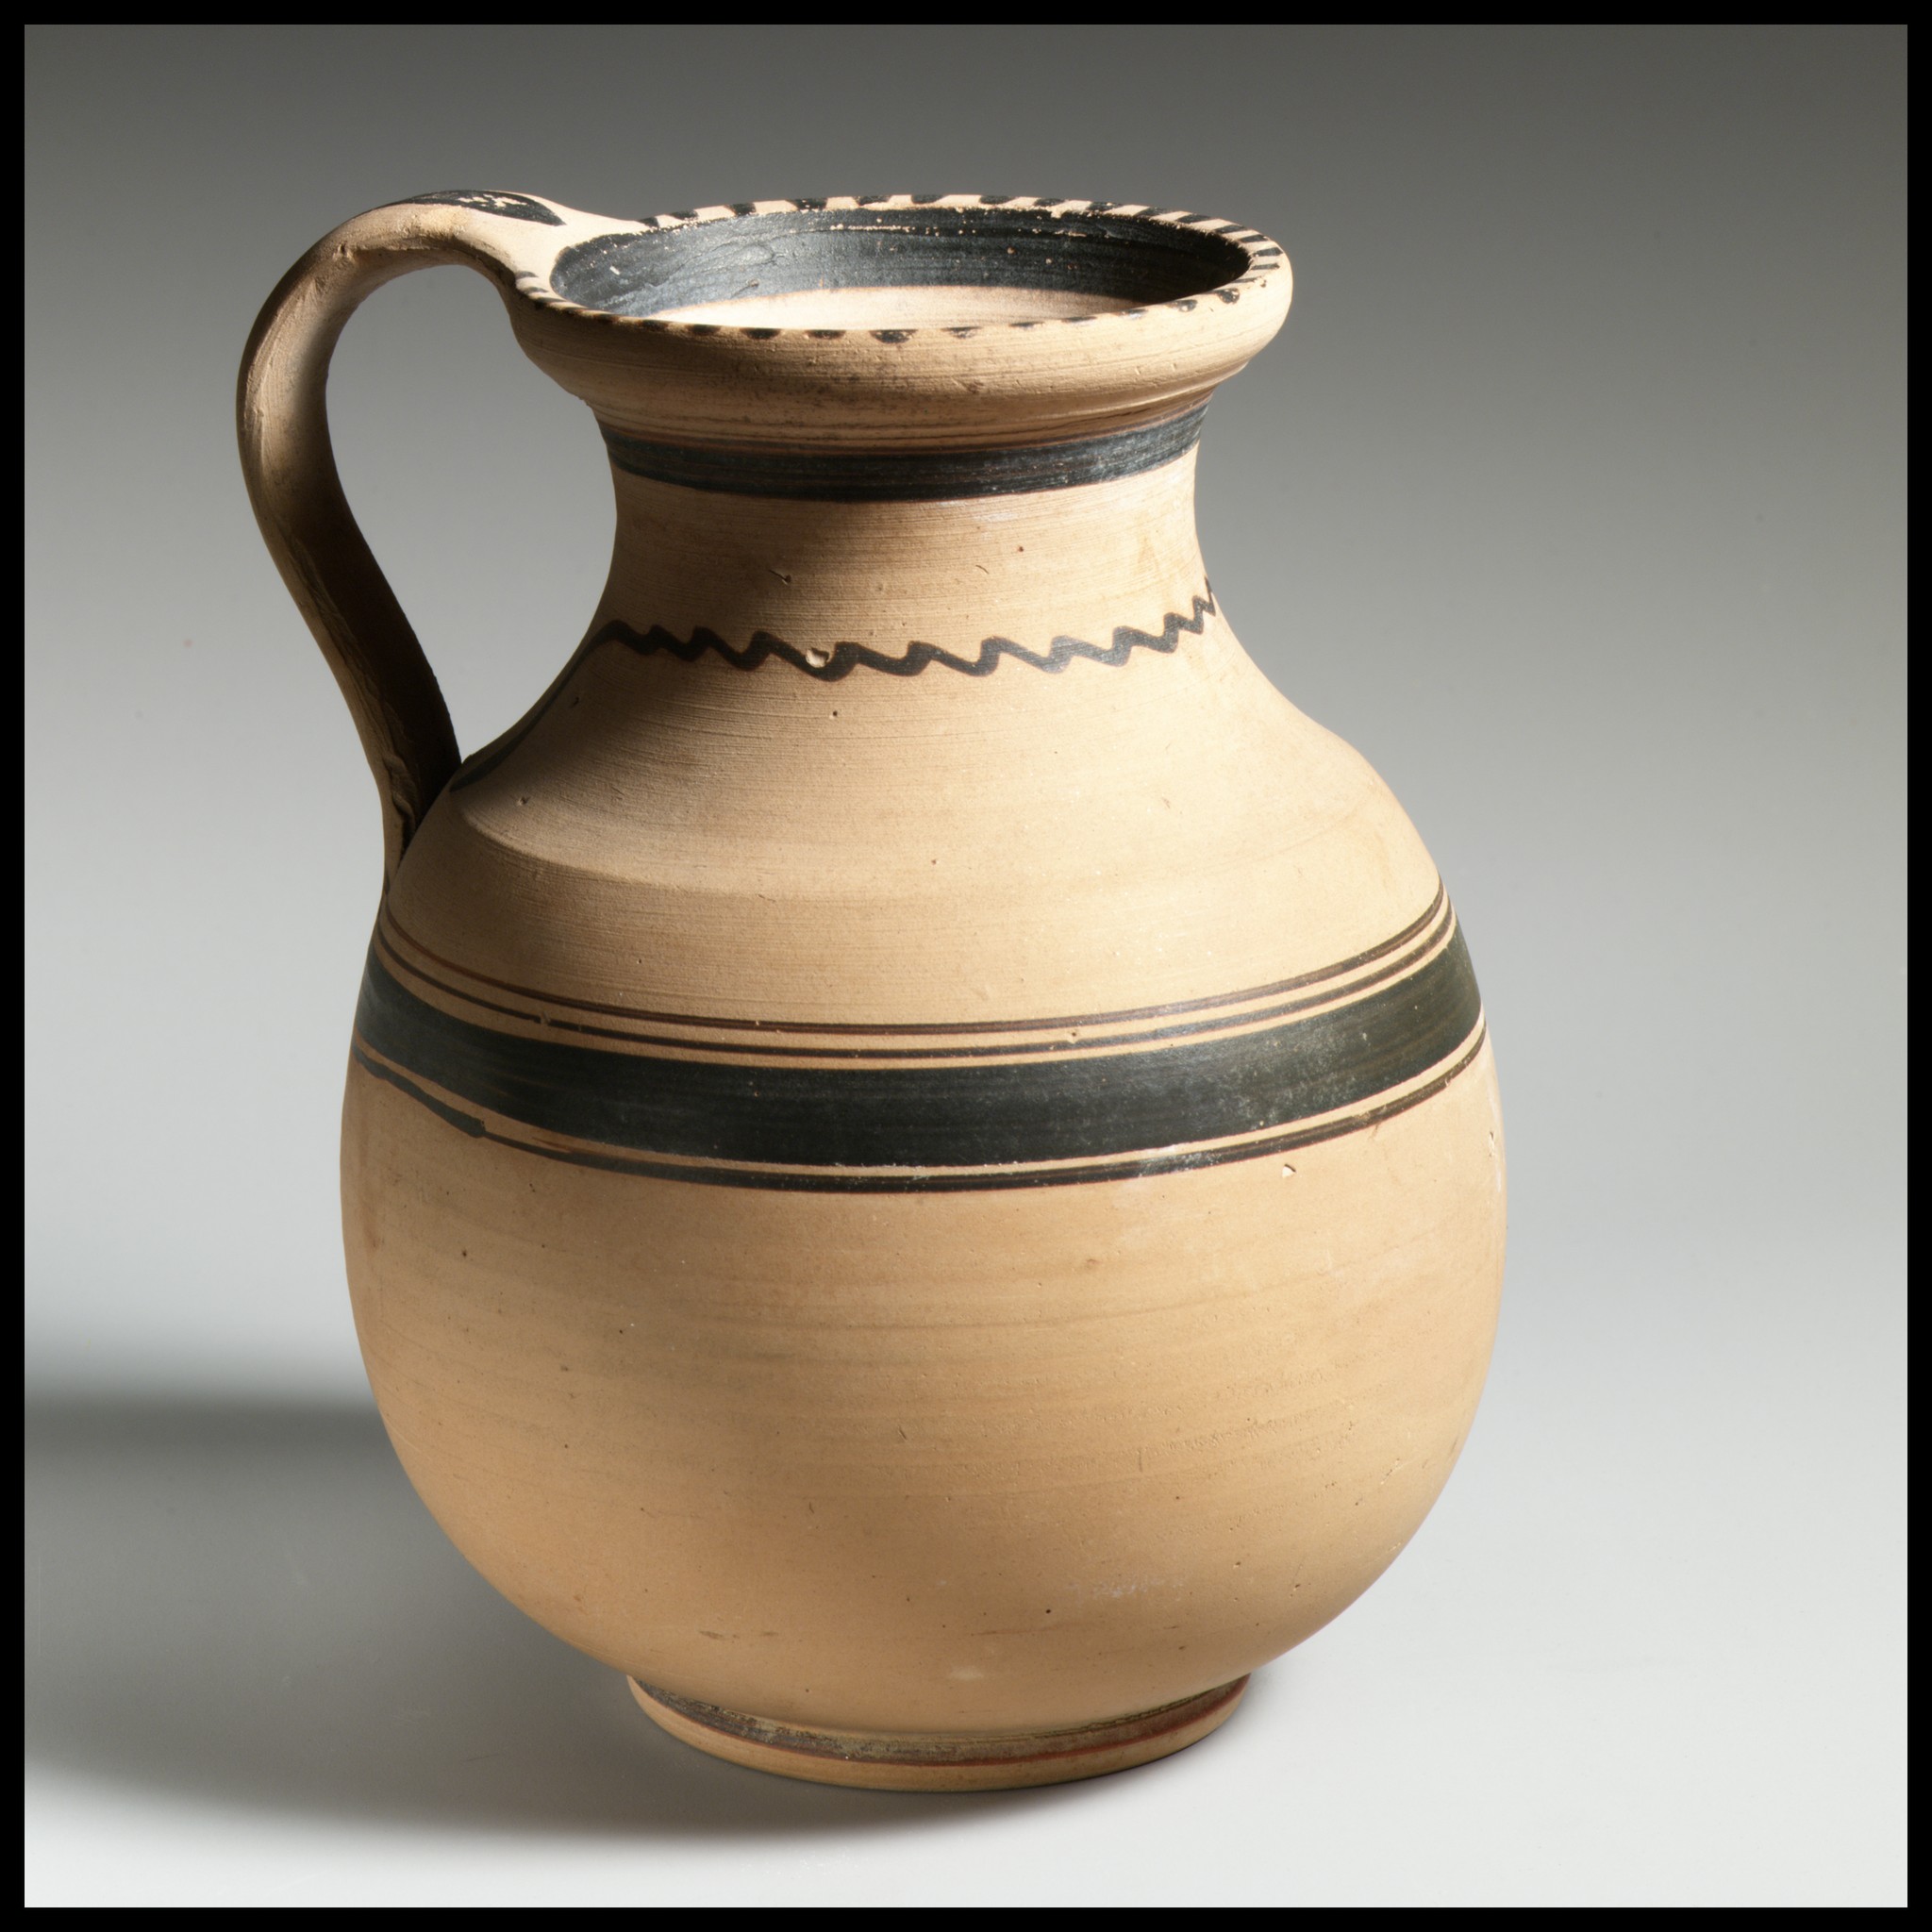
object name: jug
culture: east greek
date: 400-301 BCE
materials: terracotta